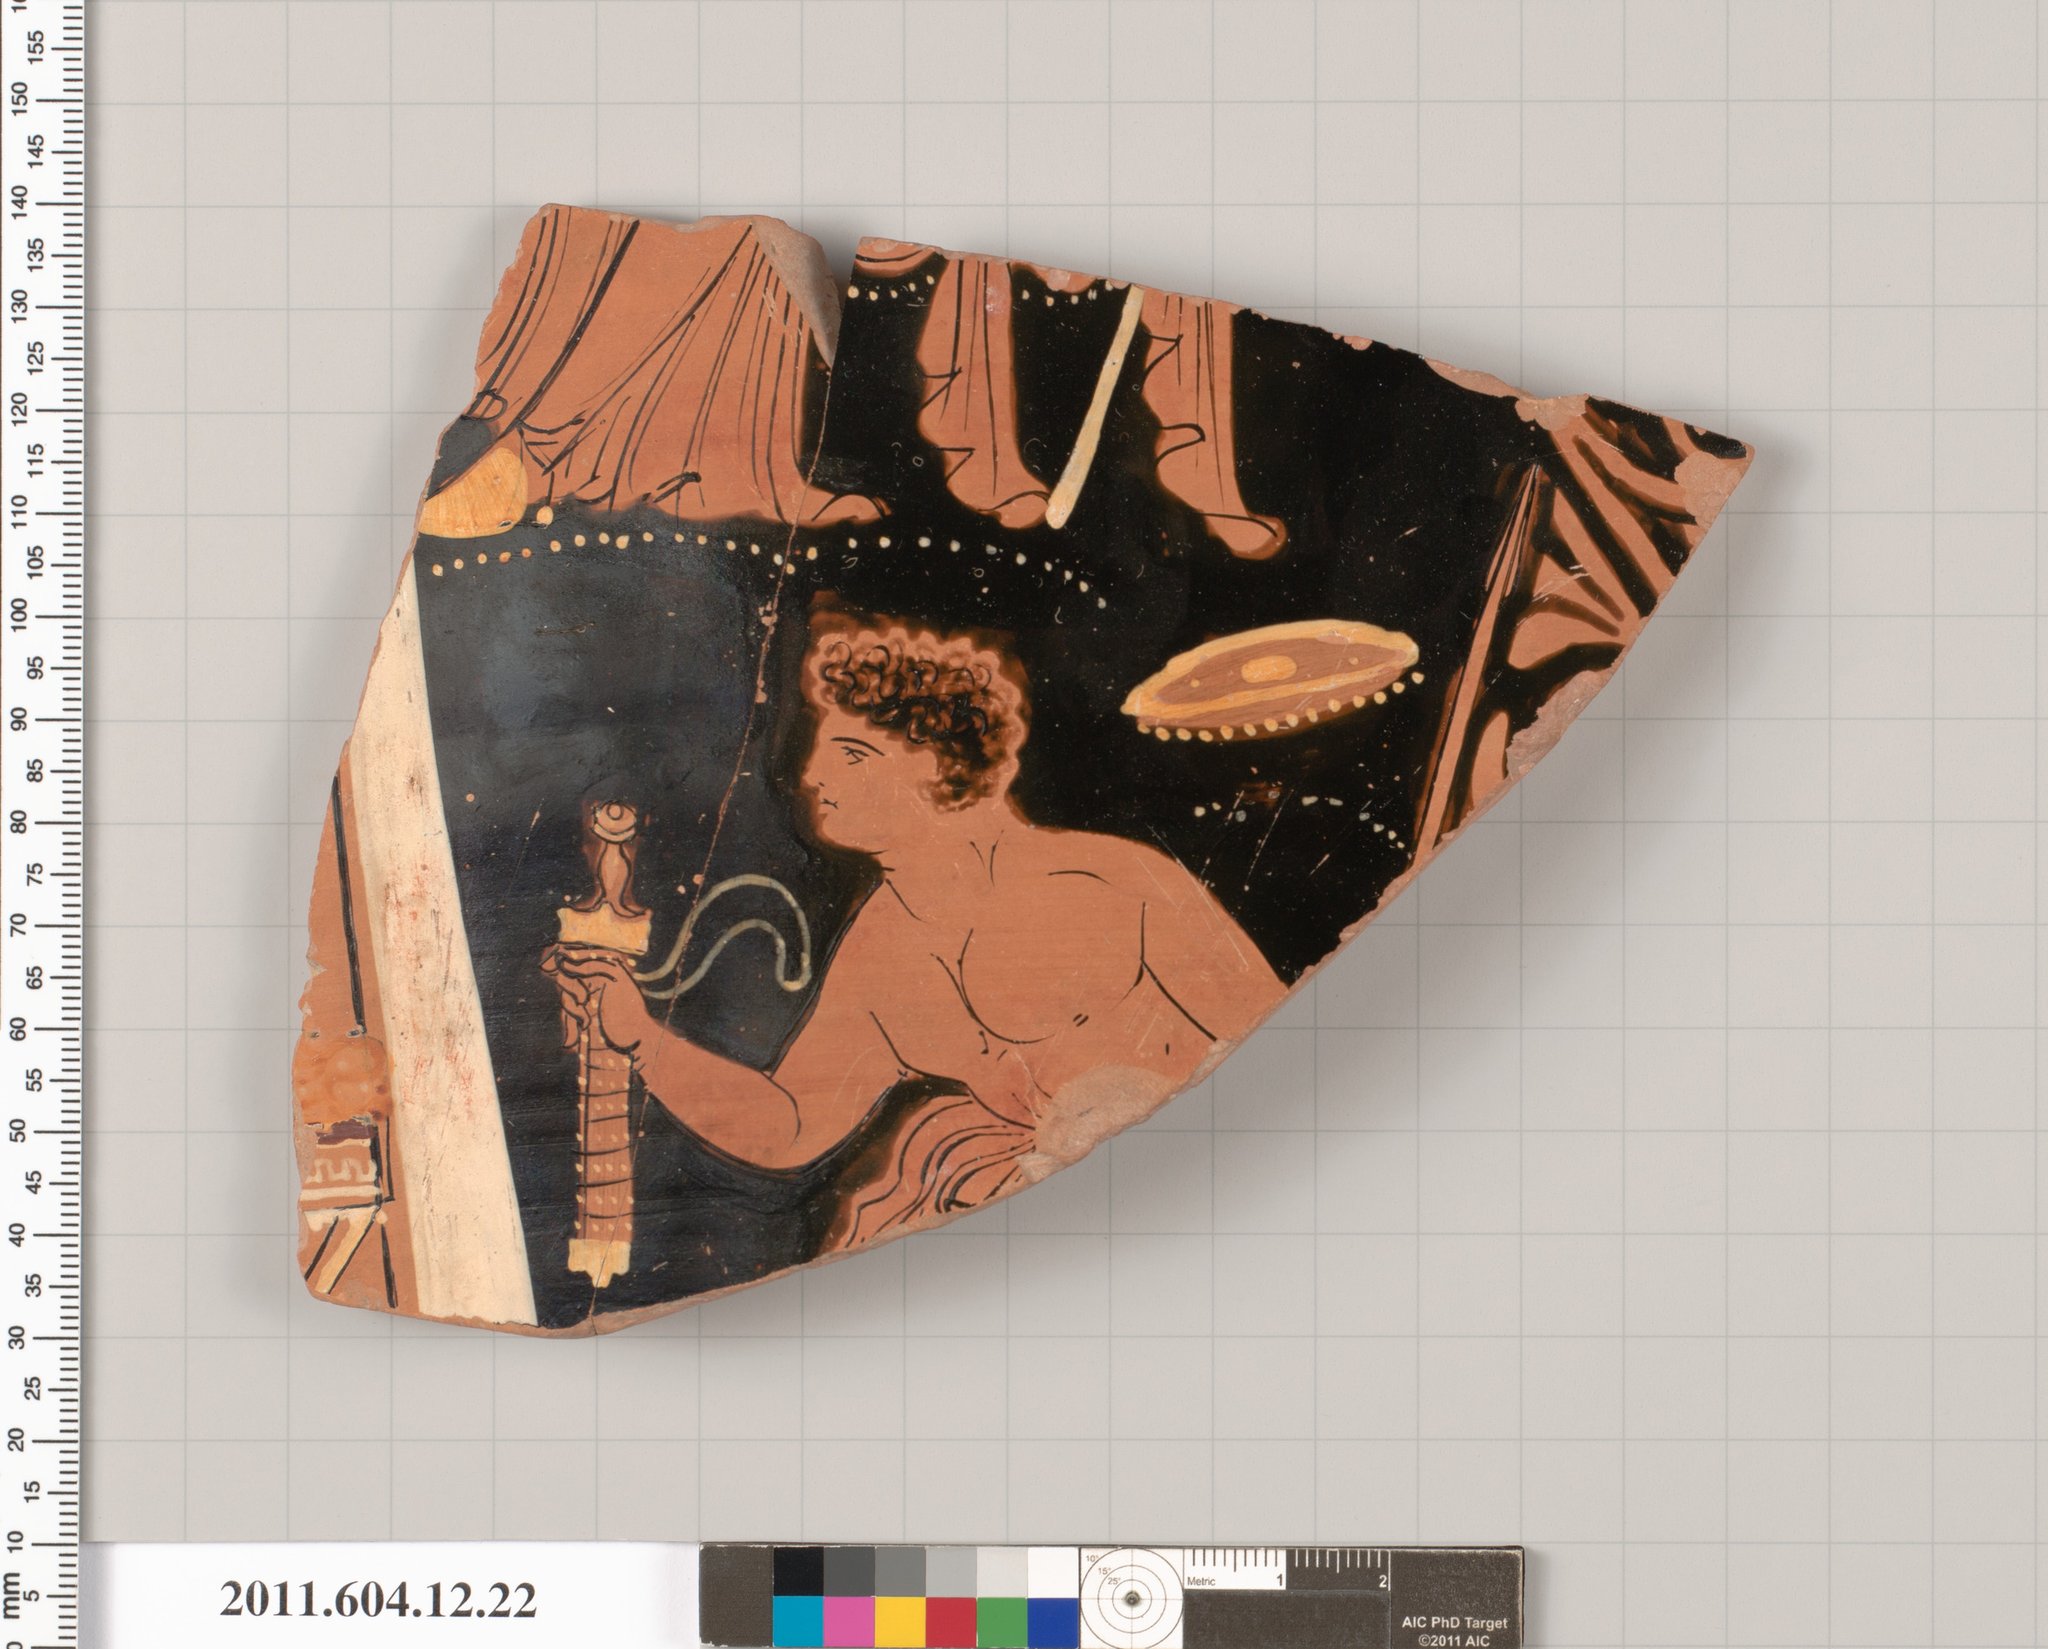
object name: undetermined closed shape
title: Terracotta fragment of a closed shape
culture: greek, south italian, apulian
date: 400-301 BCE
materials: terracotta